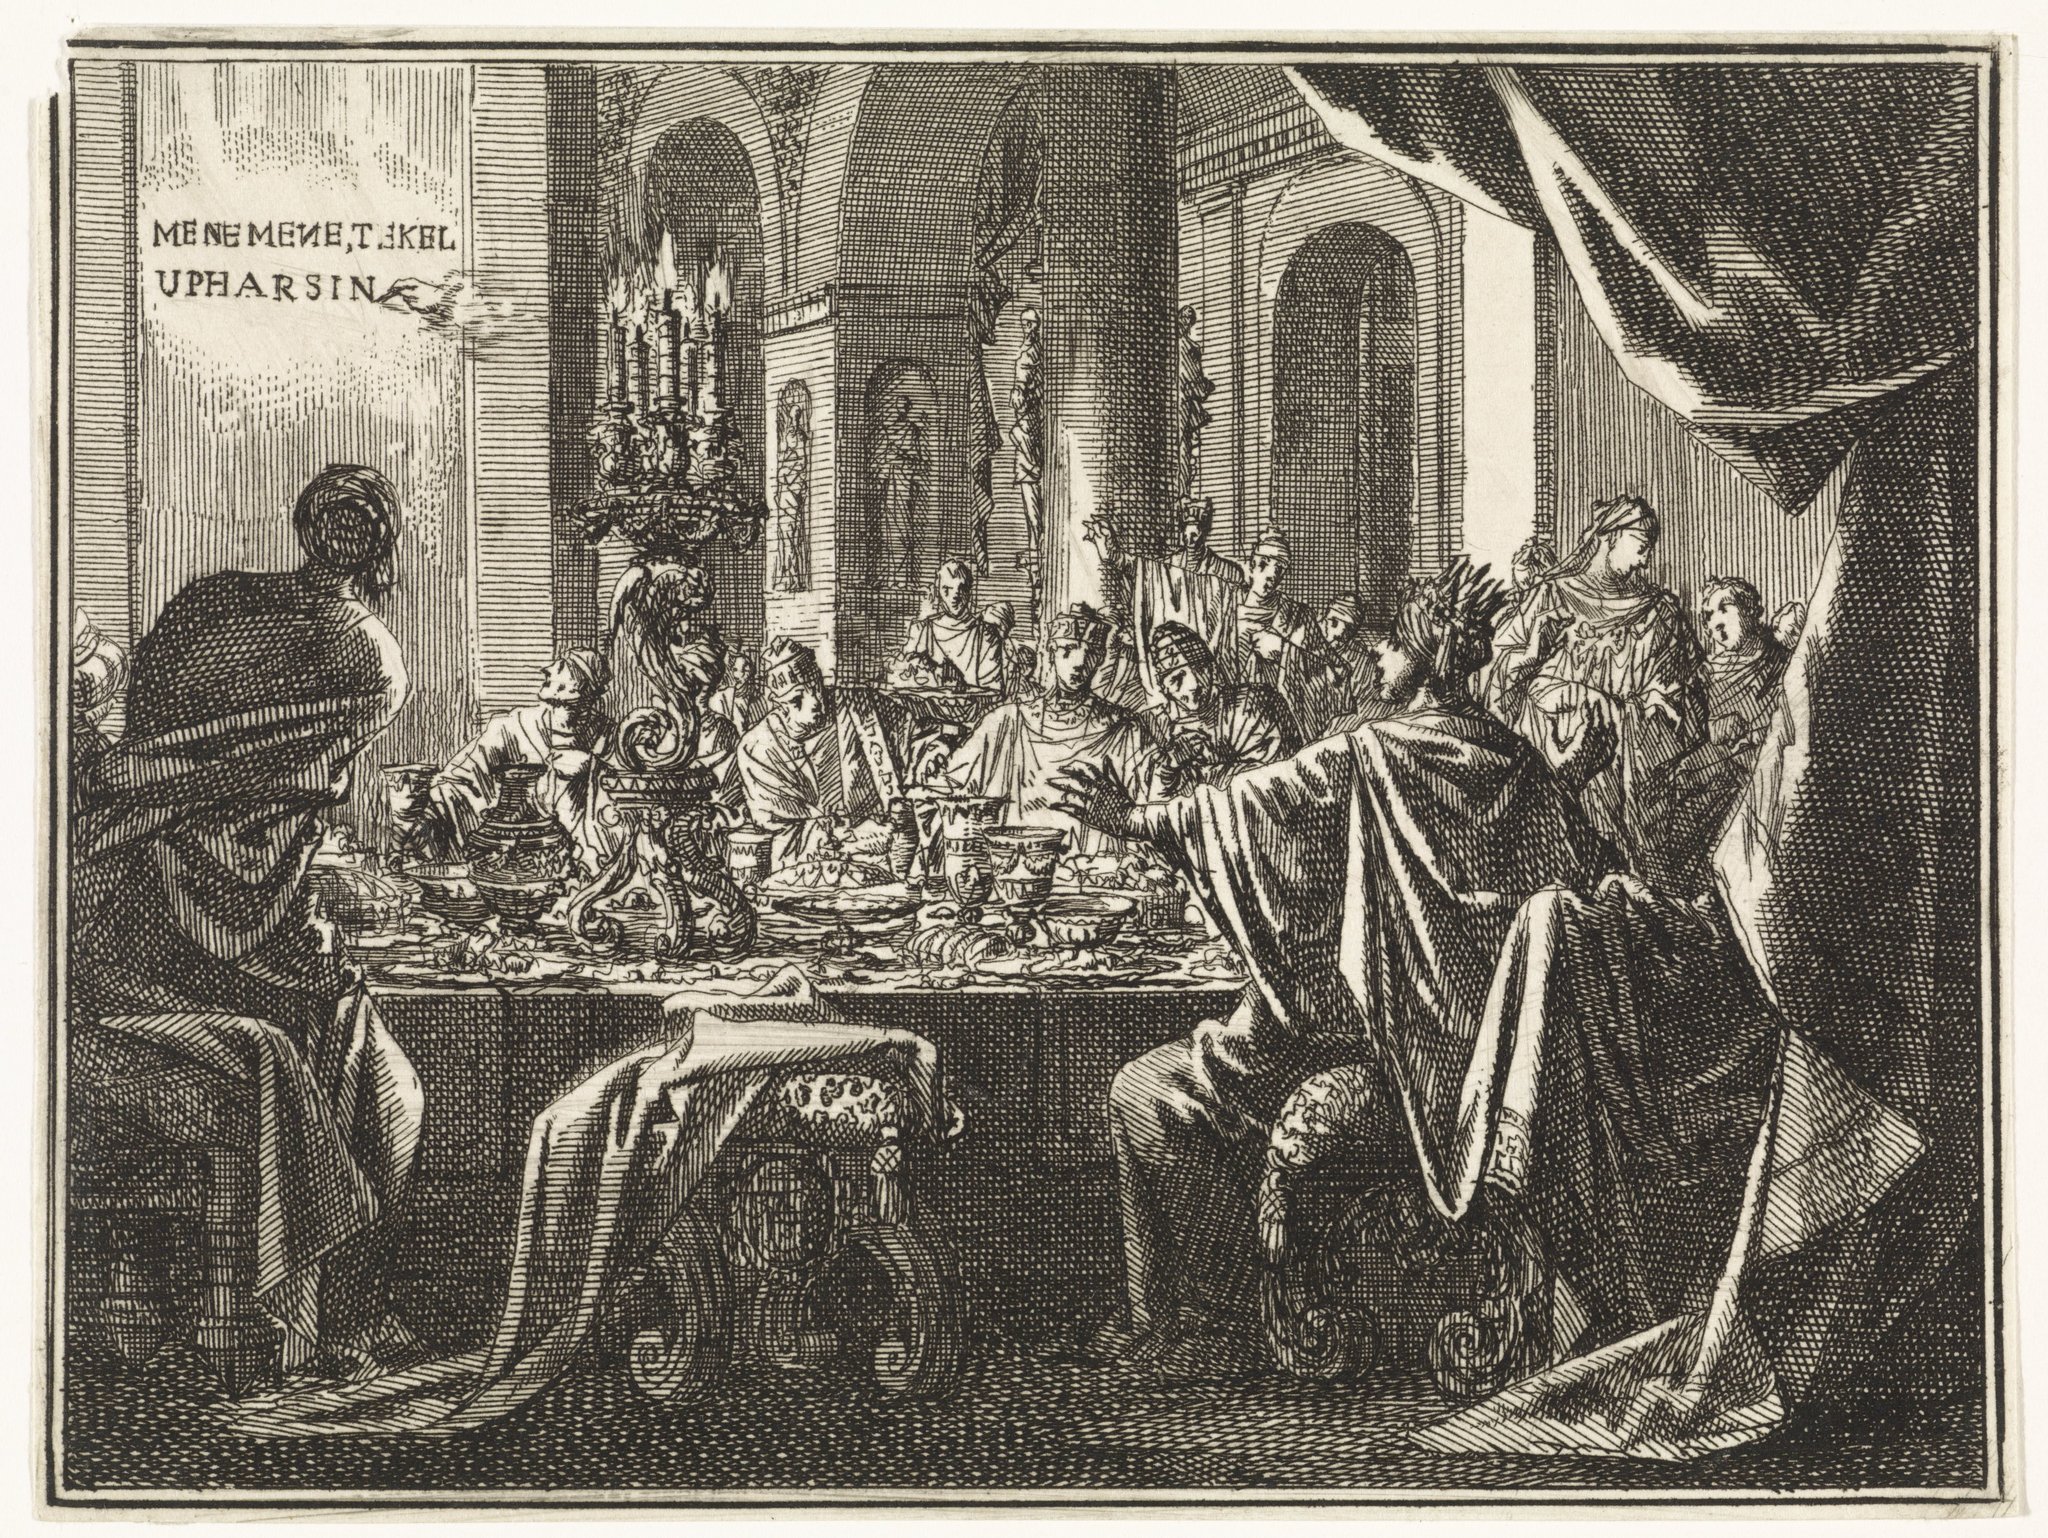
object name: print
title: Feestmaal van Belsassar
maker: jan luyken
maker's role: draughtsman, print maker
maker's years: 1649-1712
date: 1712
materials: paper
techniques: etching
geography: amsterdam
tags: during belshazzar's banquet a hand appears and writes on the wall (mene, mene, tekel and parsin (upharsin)); king belshazzar is frightened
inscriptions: collector's mark: Lugt 2228, number: ‘165’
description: Illustratie uit: Luyken, Jan. De schriftuurlyke geschiedenissen en gelykenissen van het Oude en Nieuwe Verbond, 2 delen. Amsterdam: Wed. Pieter Arentsz II en Cornelis van der Sys, 1712, dl. I.